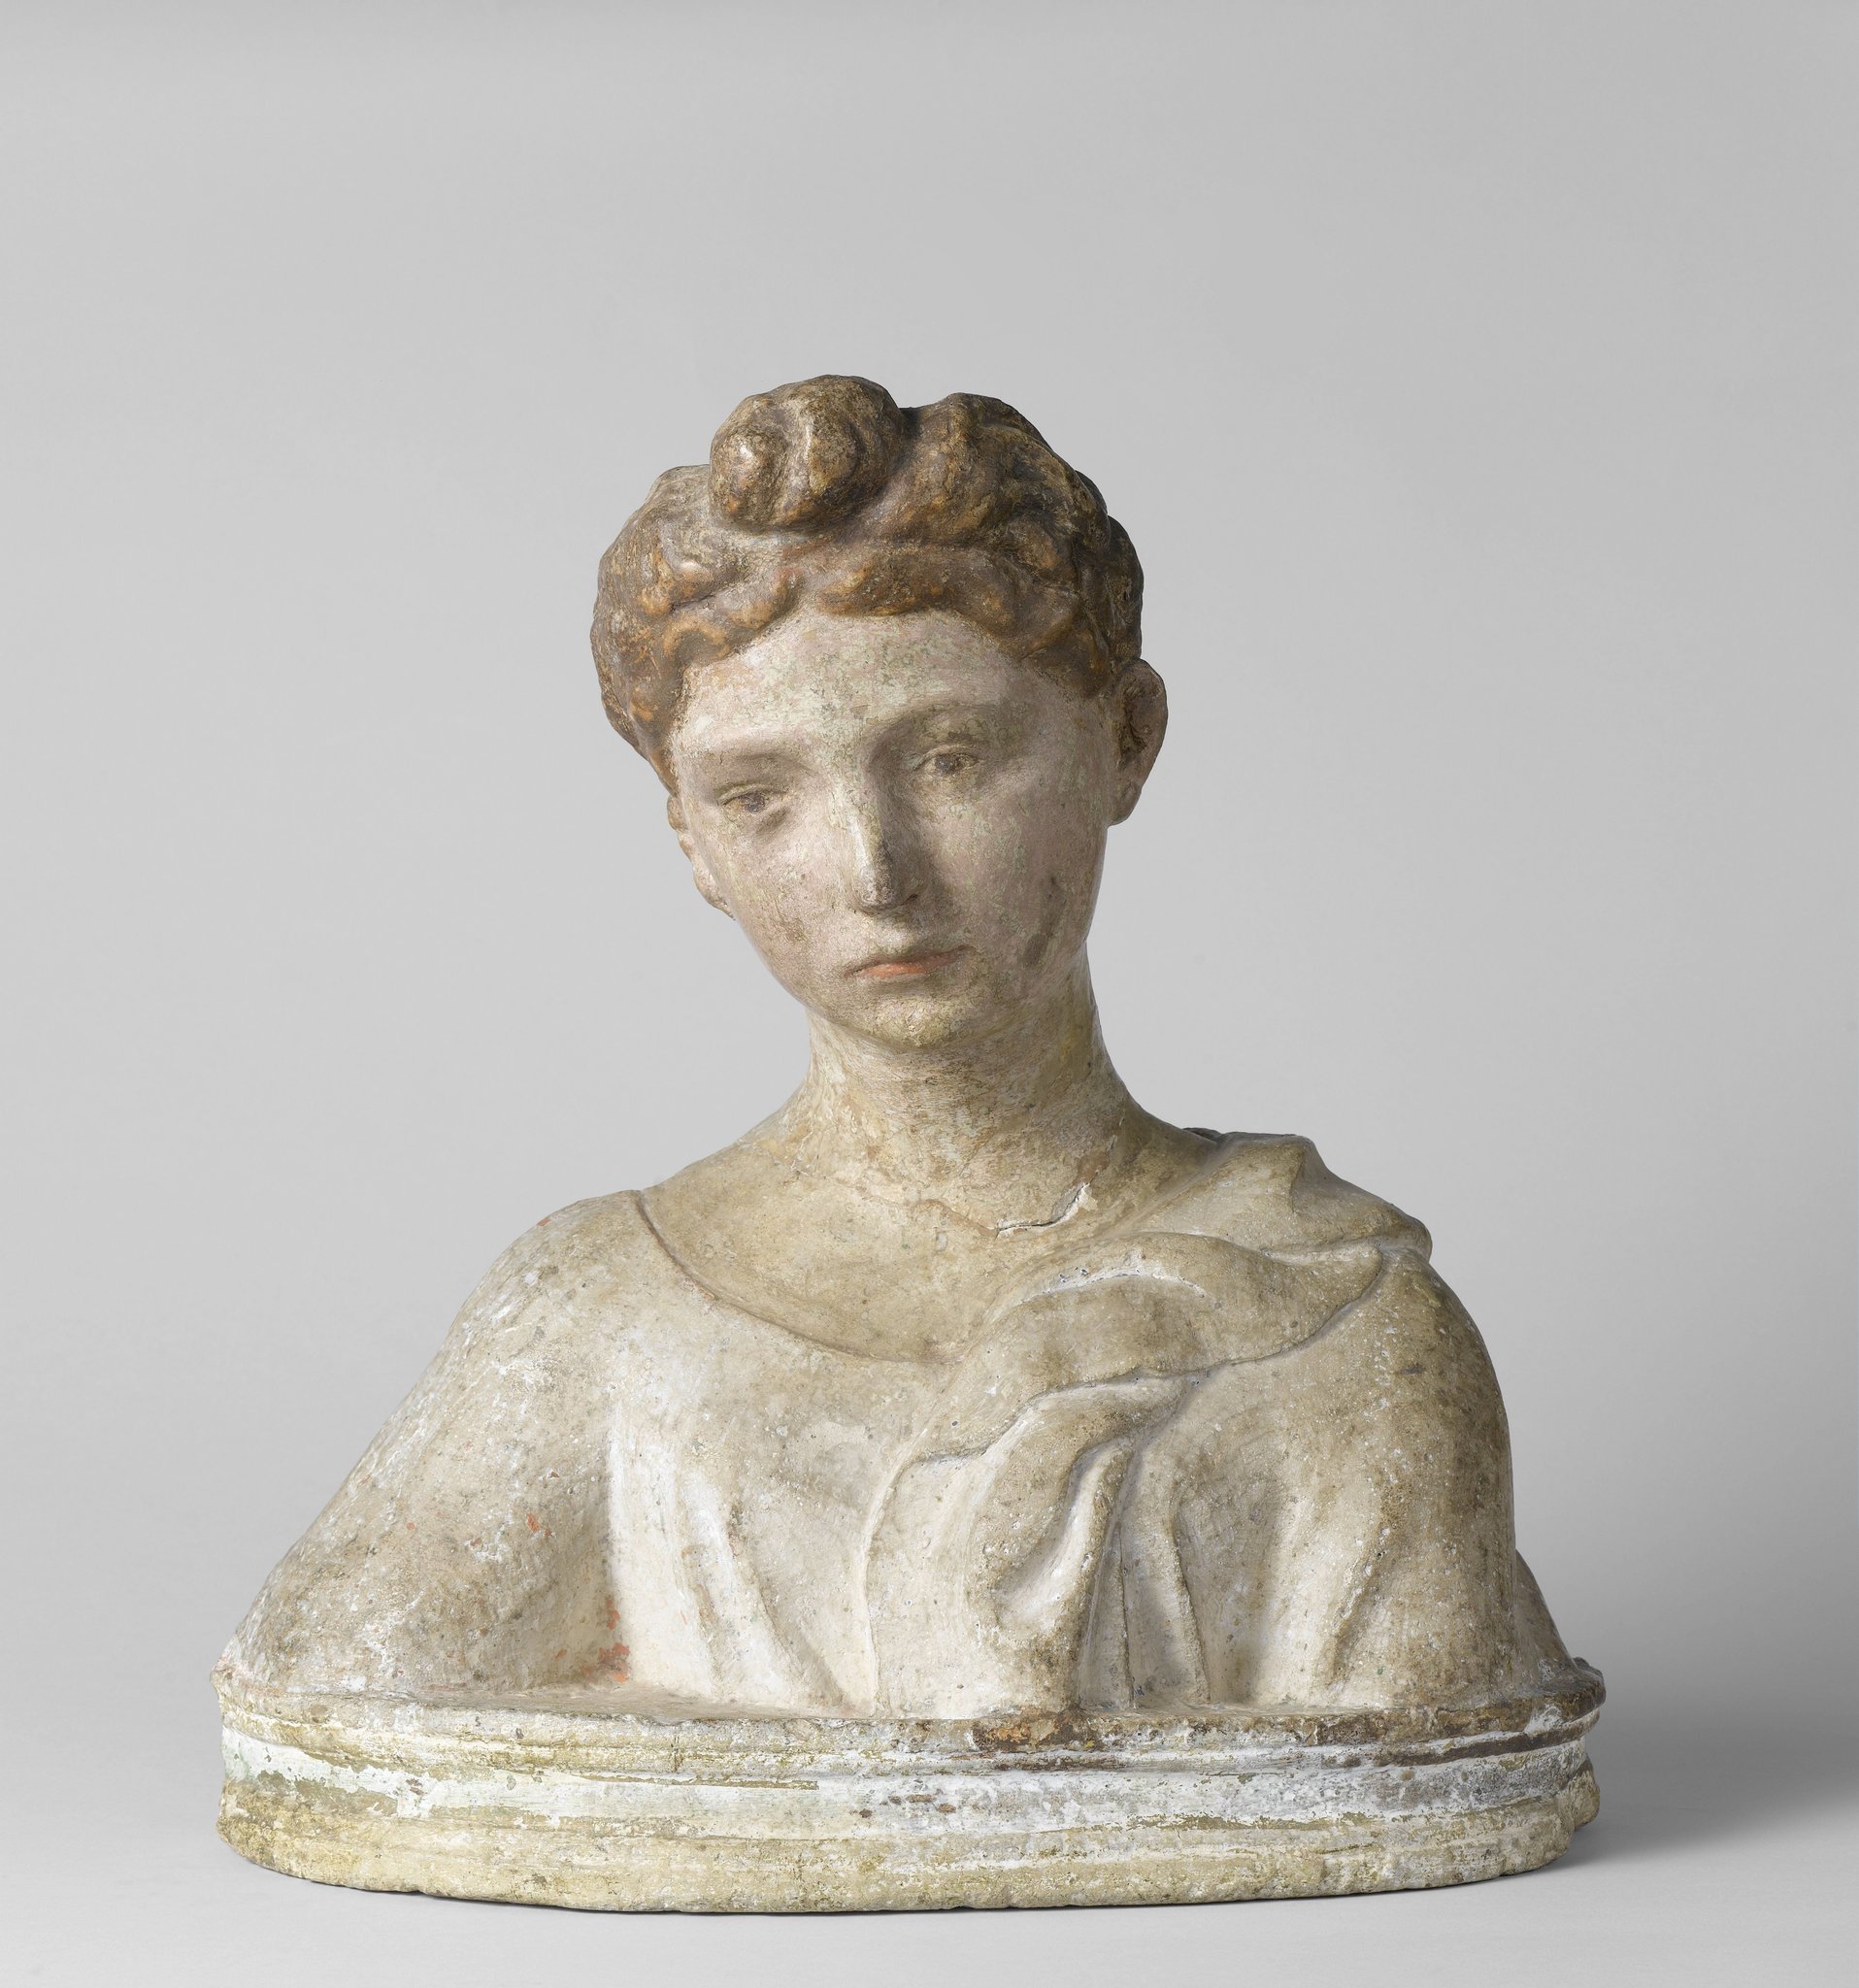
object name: sculpture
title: Borstbeeld van een jonge vrouw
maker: jacopo della quercia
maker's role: sculptor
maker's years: 1367-1438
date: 1400-1440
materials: plaster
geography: italy